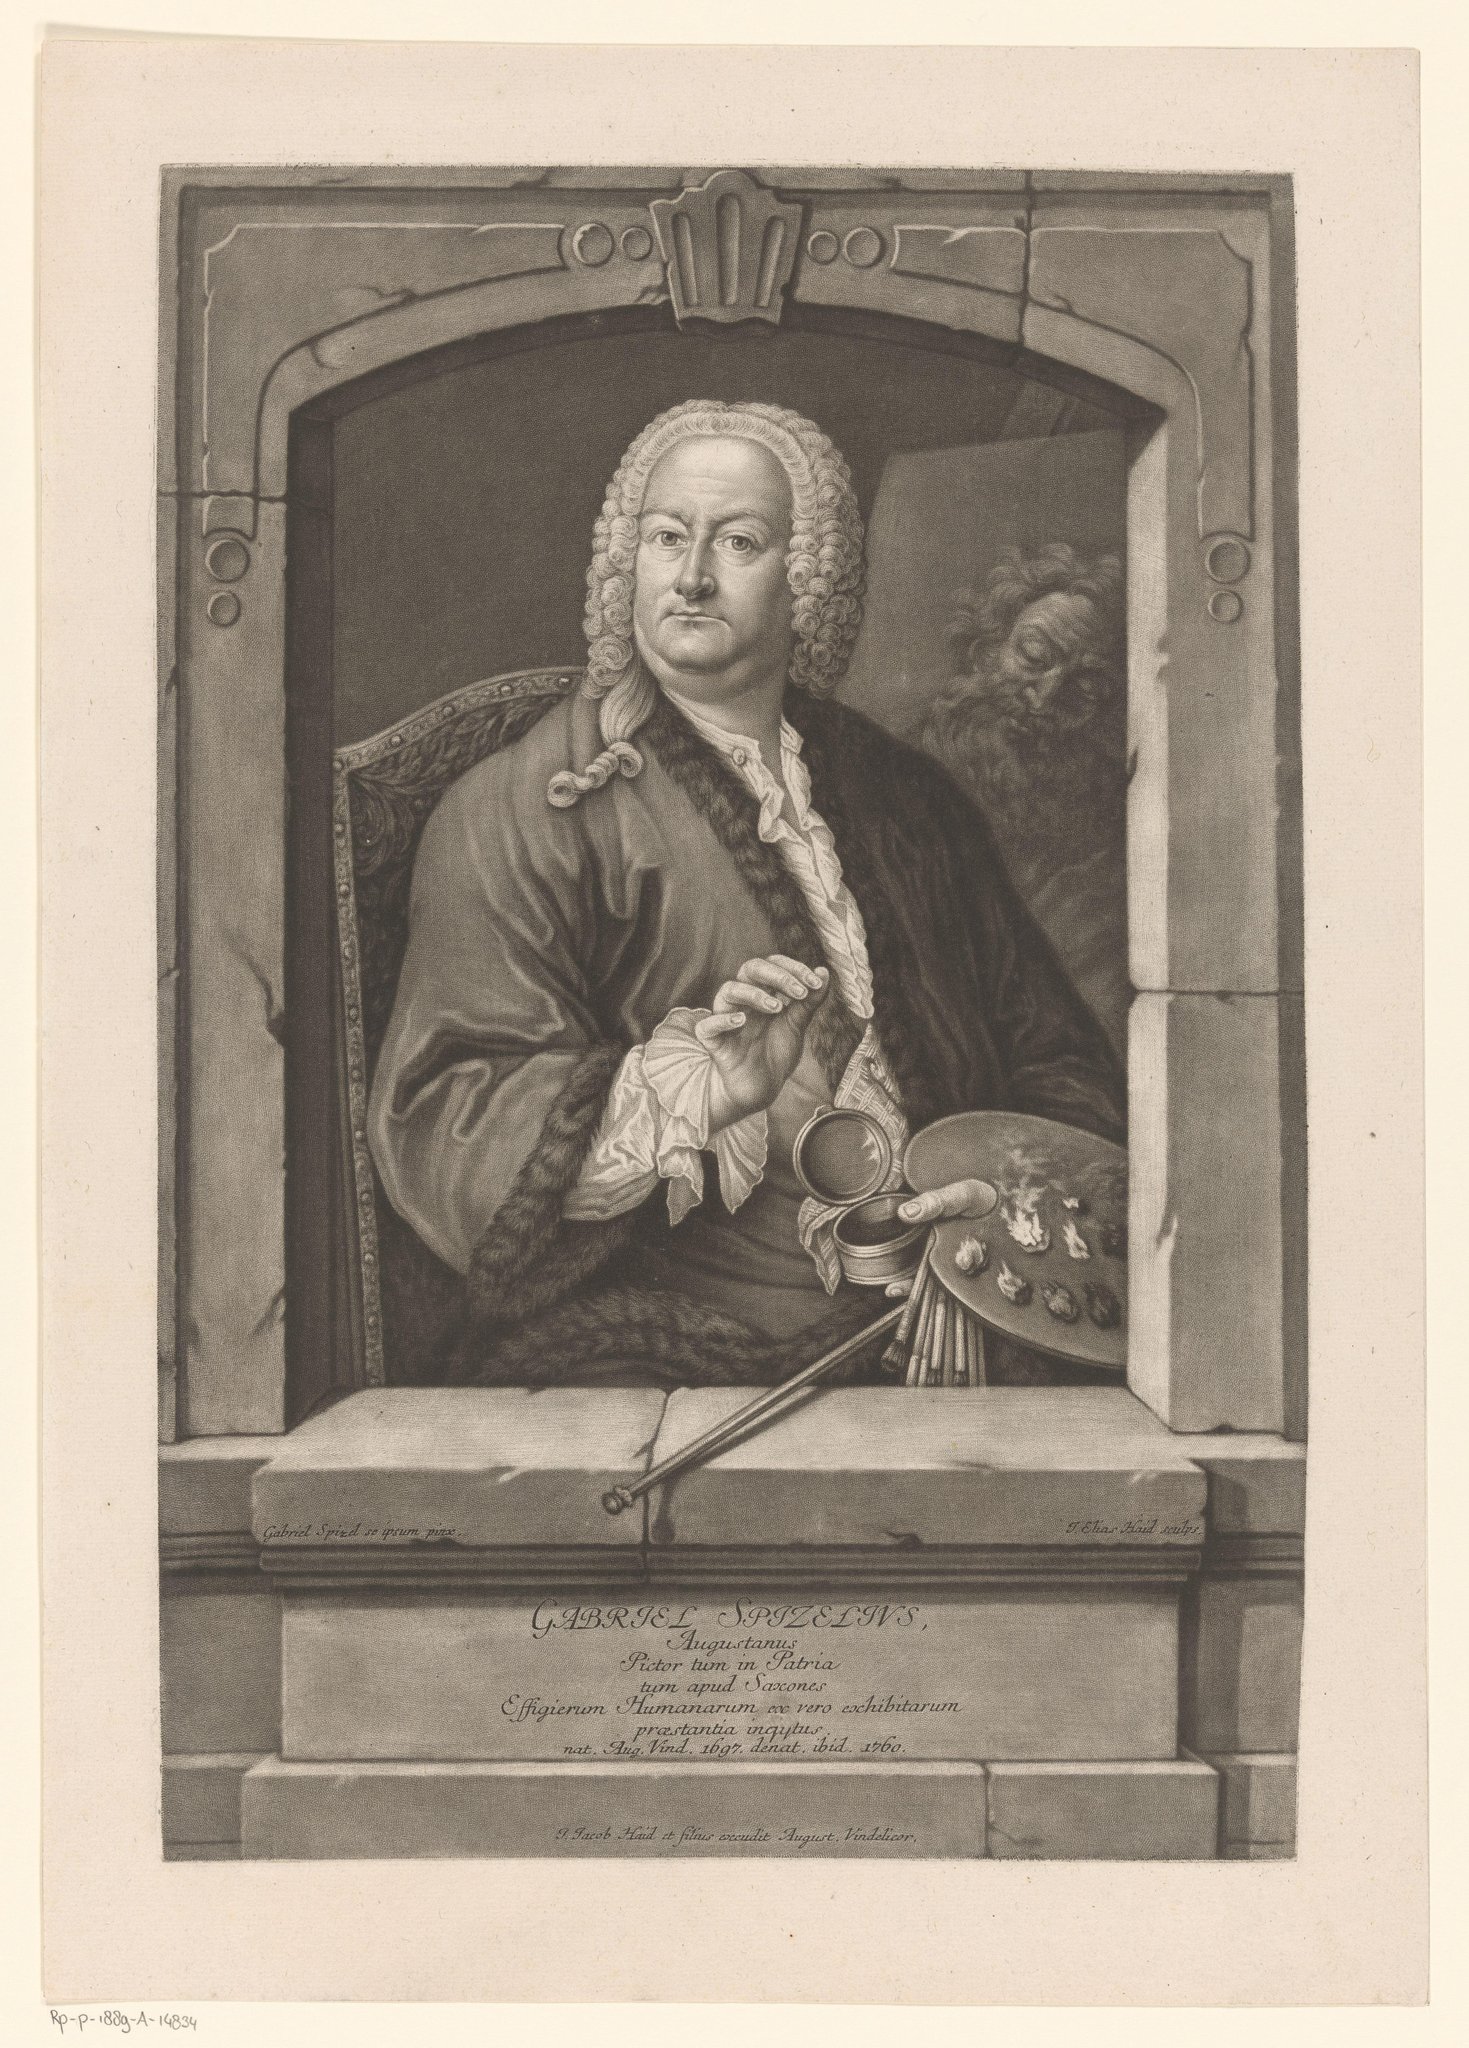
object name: print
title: Portret van Gabriel Spitzel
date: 1760-1809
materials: paper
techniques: mezzotint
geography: augsburg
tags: painter, gabriel spitzel (1697-1760), historical persons, portrait, self-portrait of painter, tools, implements of painter, human figure at (open) window, seen from outside - aa - feigned window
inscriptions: collector's mark: Lugt 2228